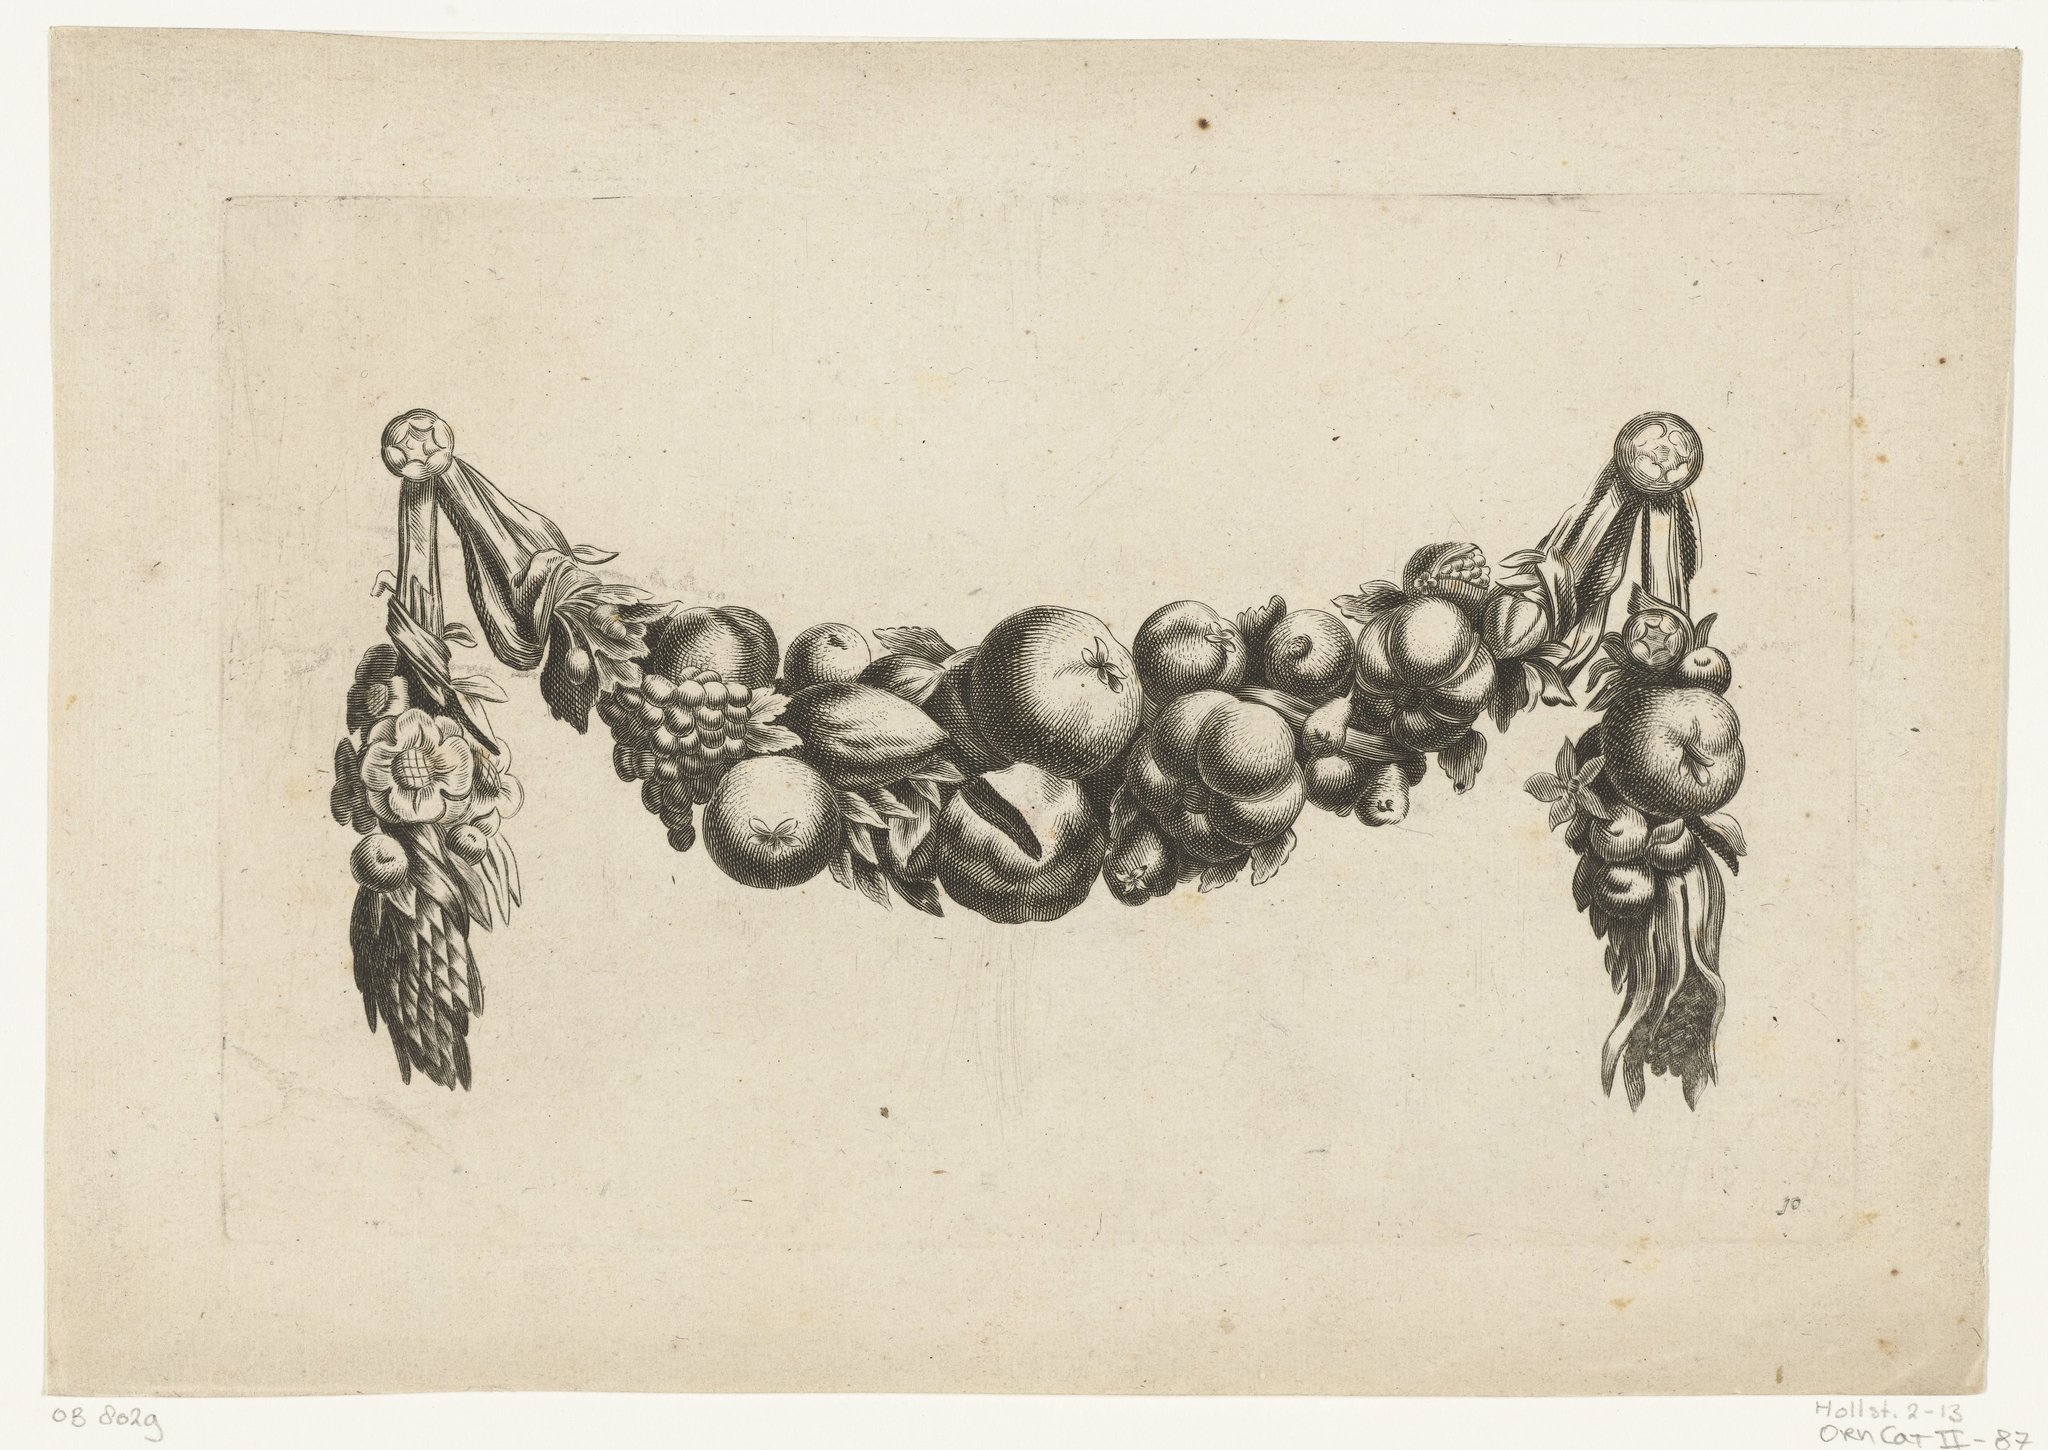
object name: ornament print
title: Festoen van fruit, met granaatappels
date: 1655-1678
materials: paper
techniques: engraving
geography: amsterdam